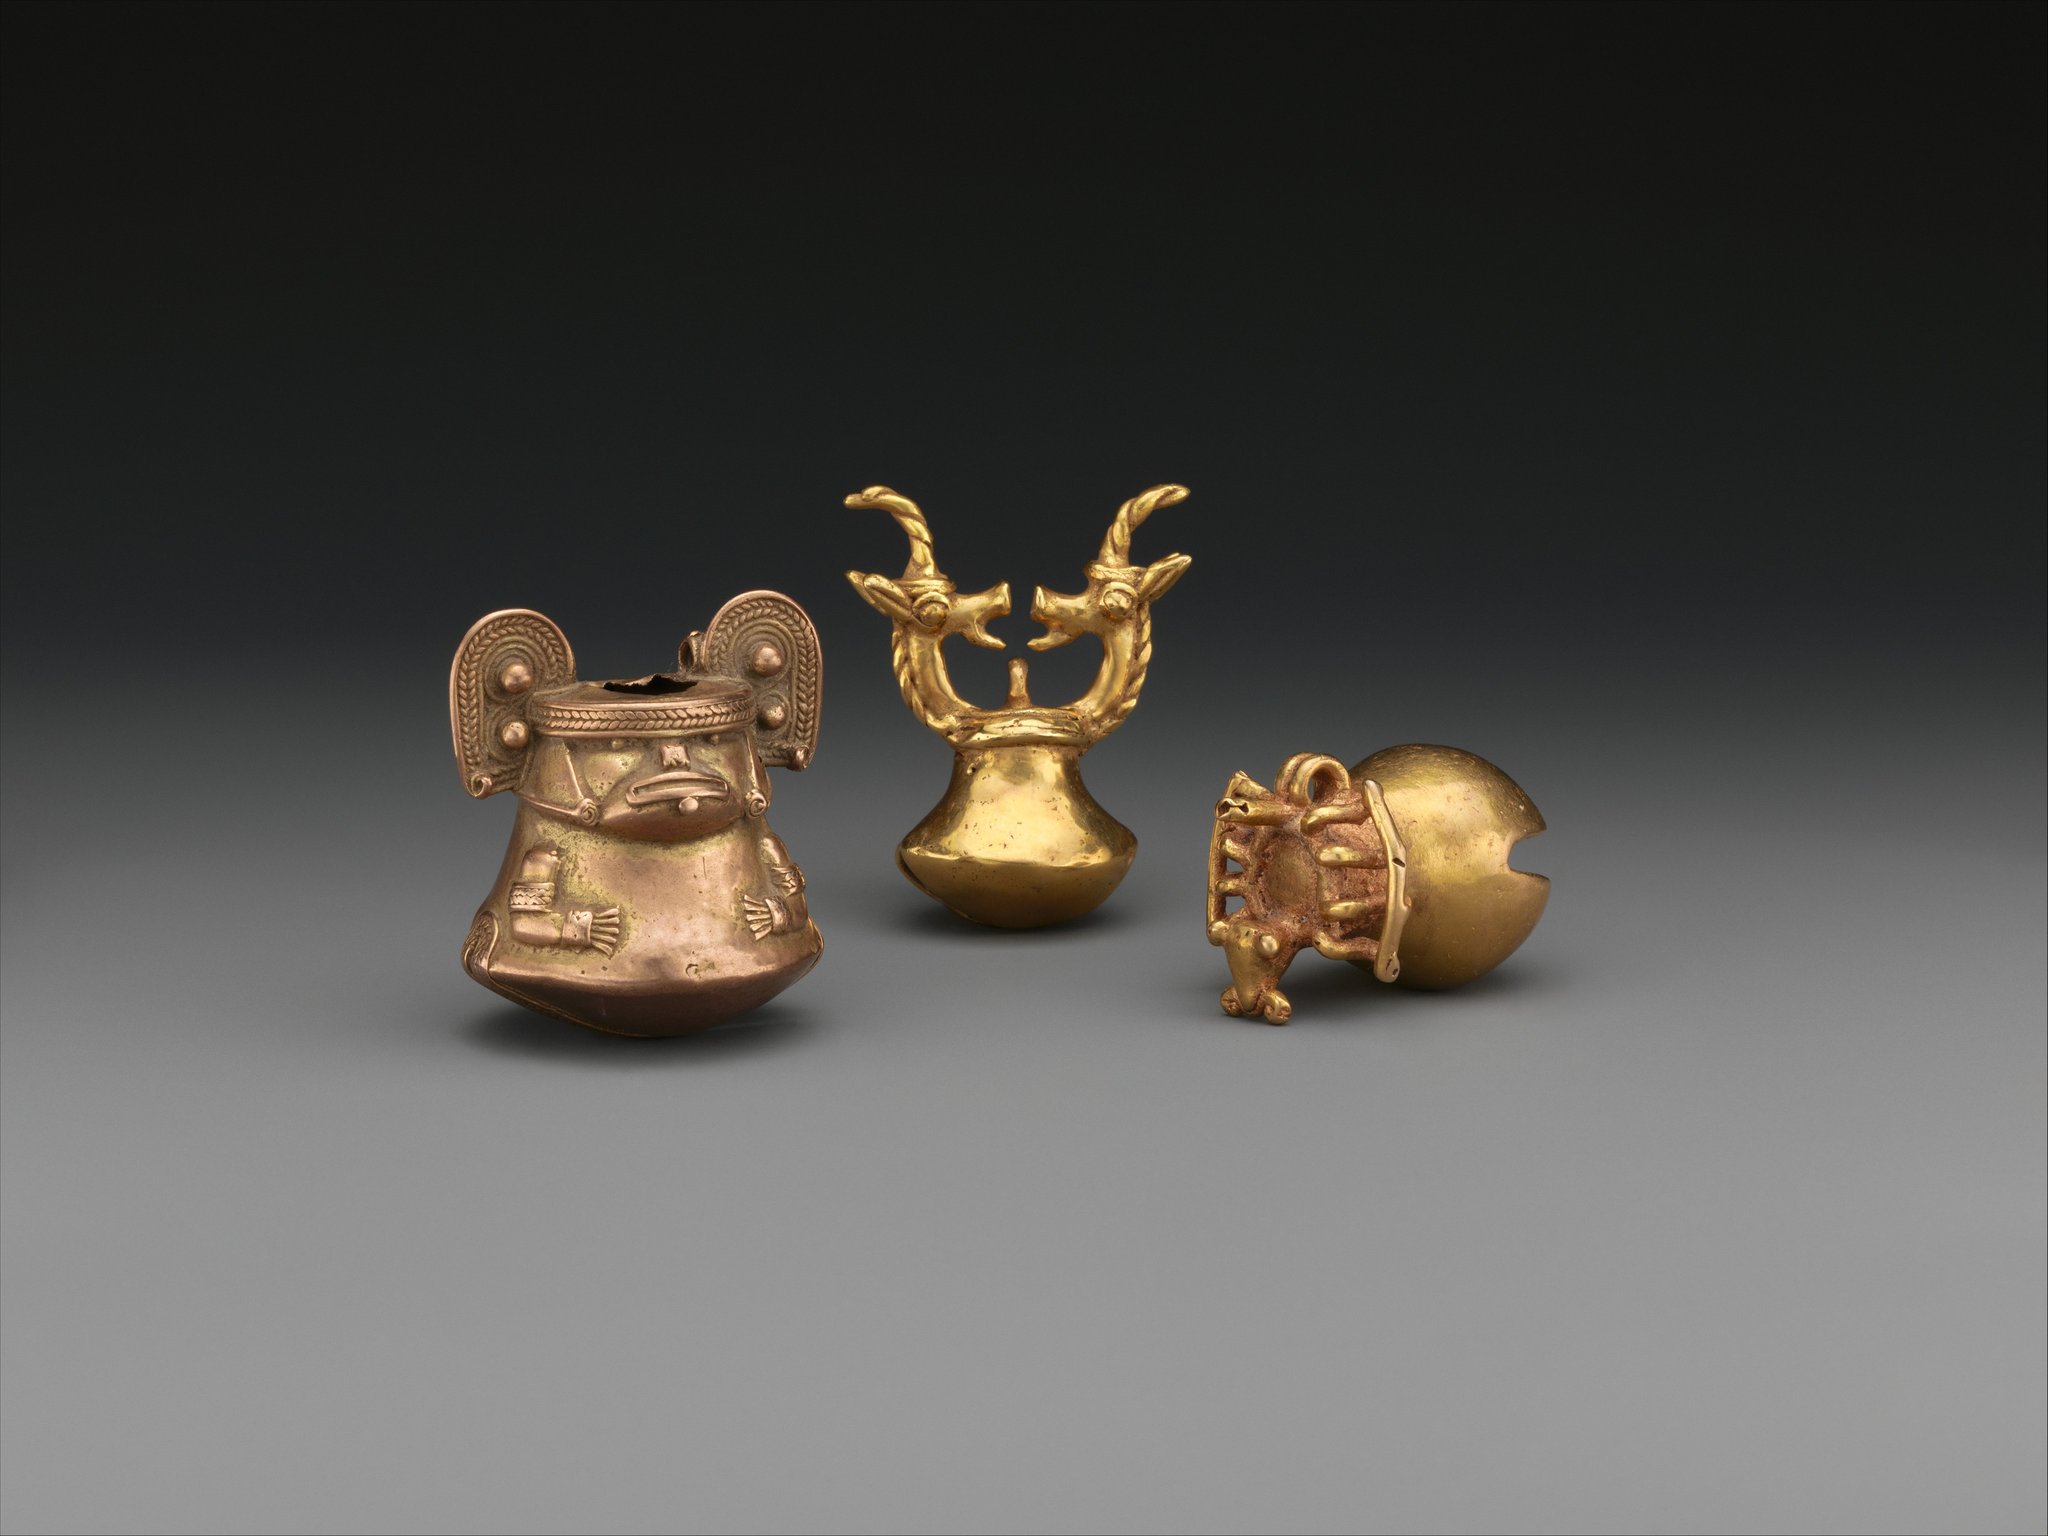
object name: bell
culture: colombian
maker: tairona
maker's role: culture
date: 1000-1500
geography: colombia